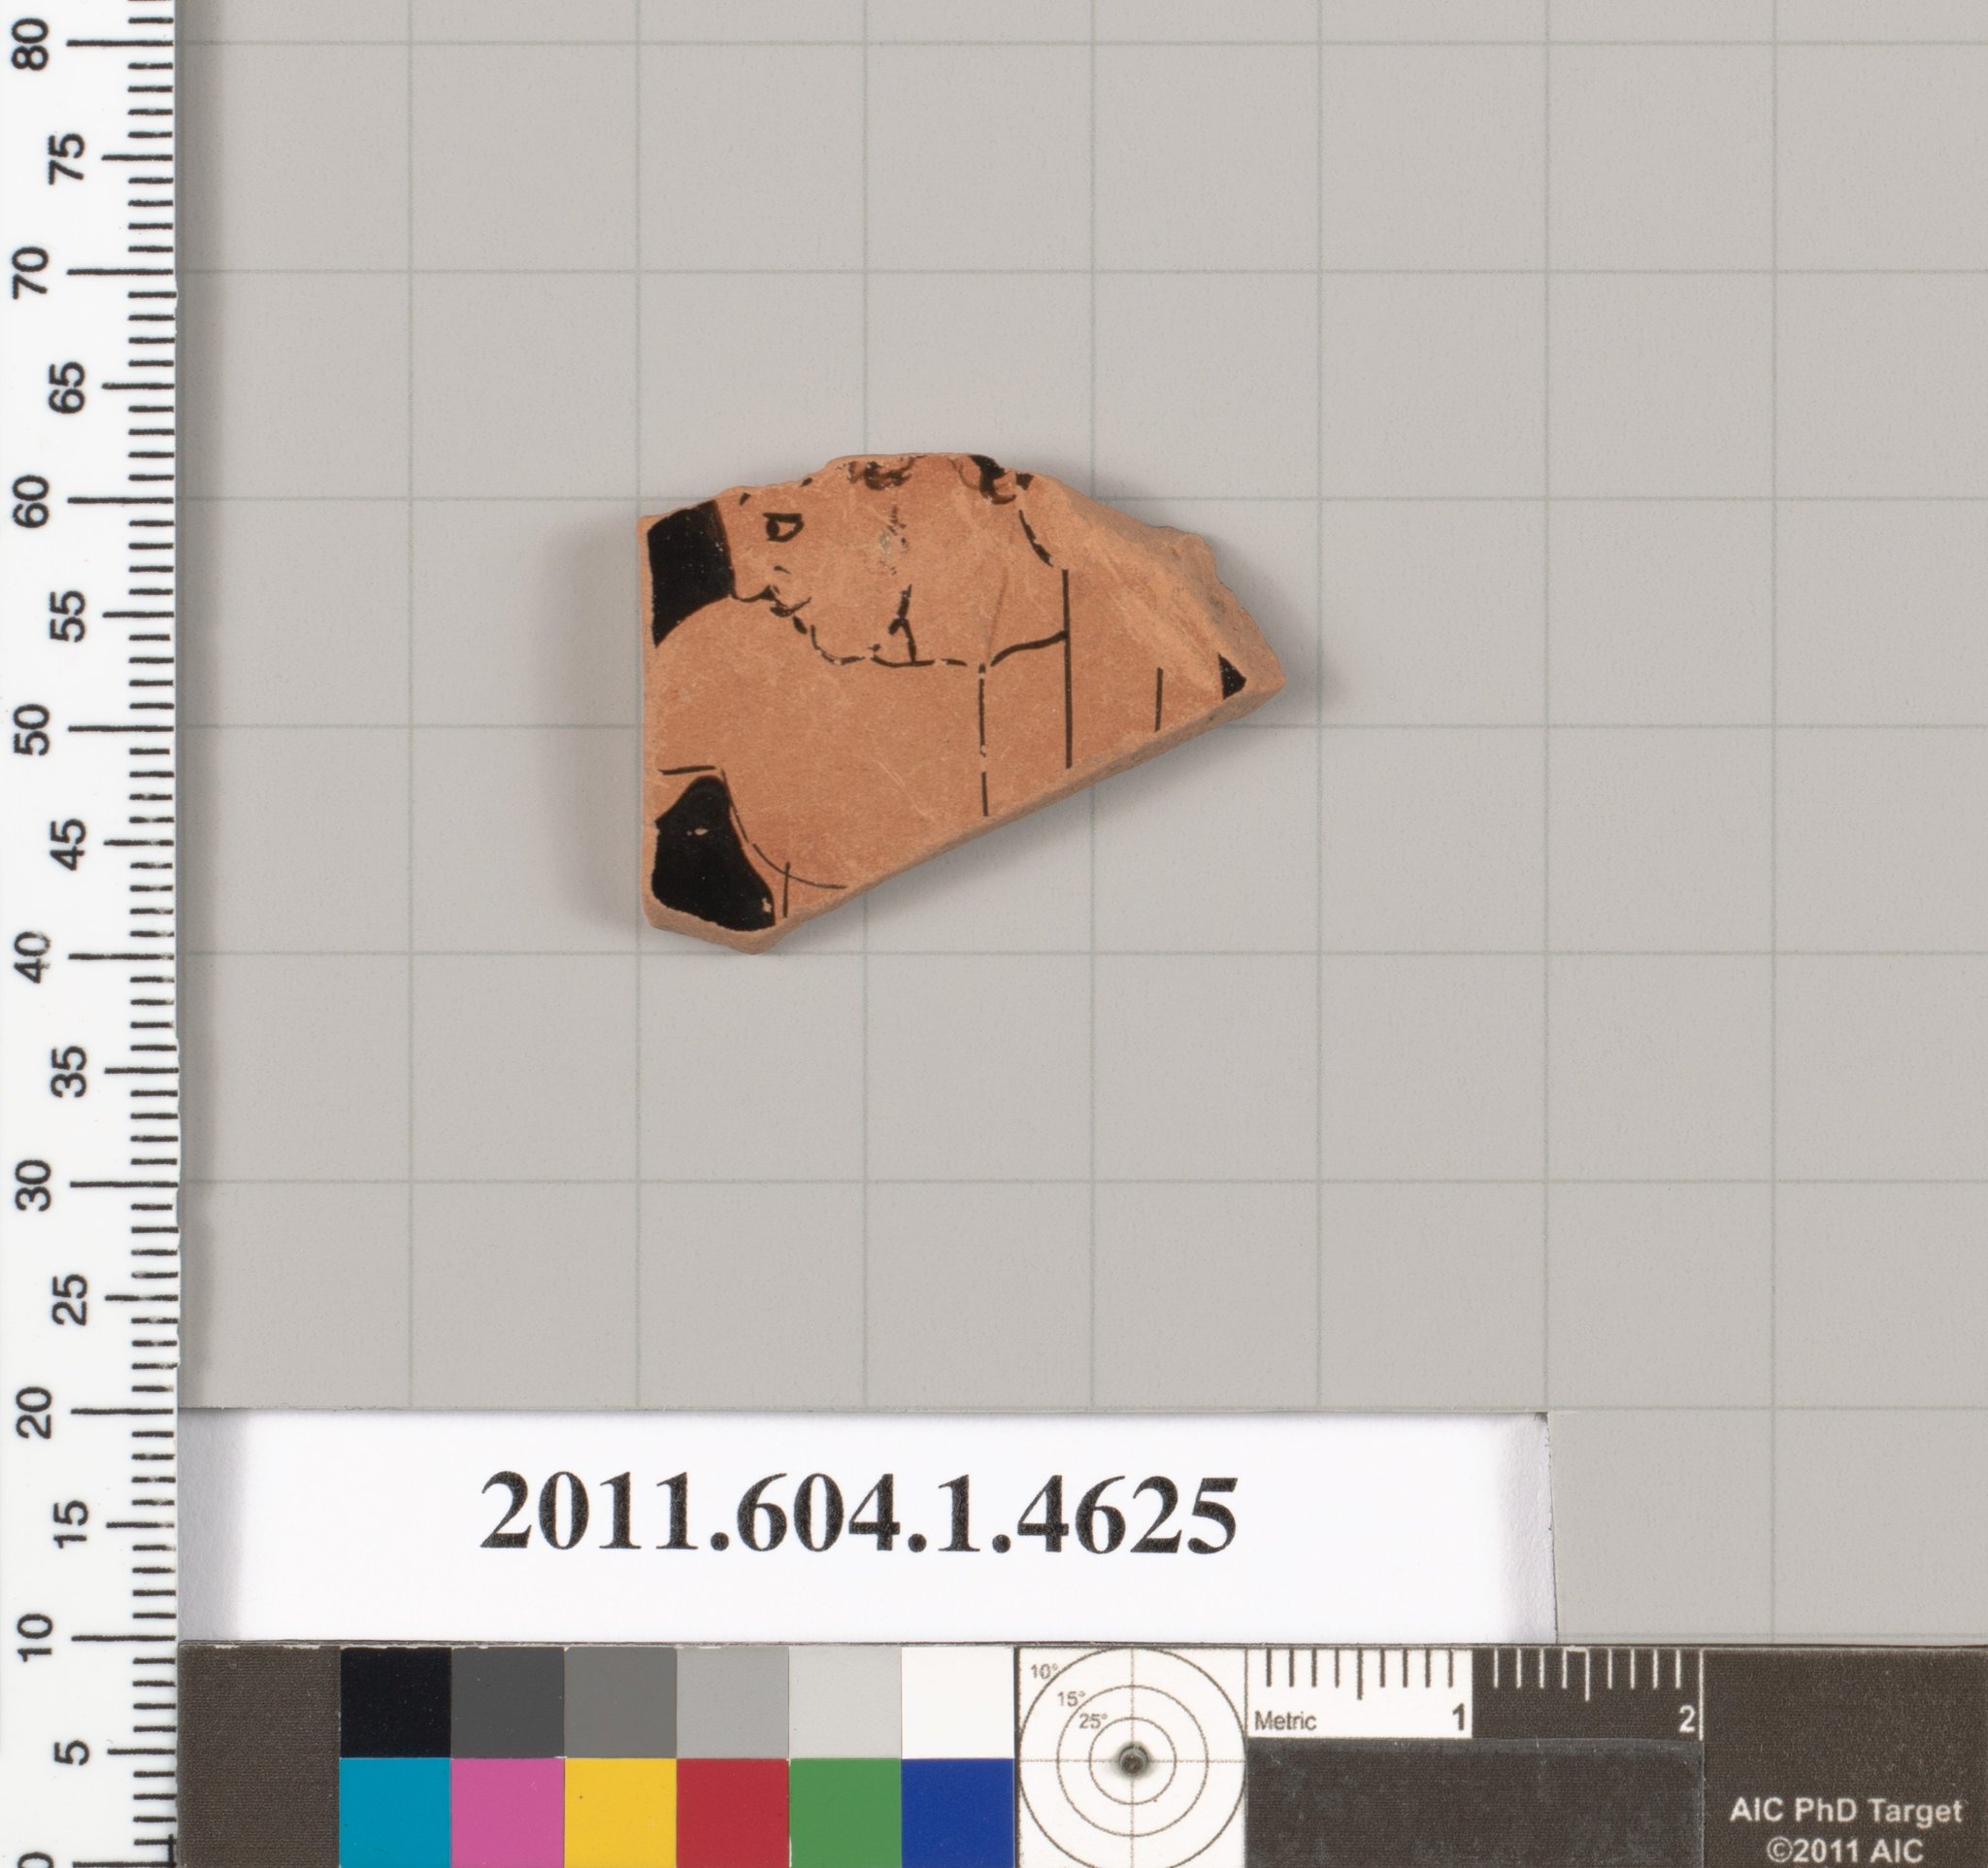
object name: kylix fragment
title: Terracotta fragment of a kylix (drinking cup)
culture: greek, attic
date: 480-470 BCE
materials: terracotta